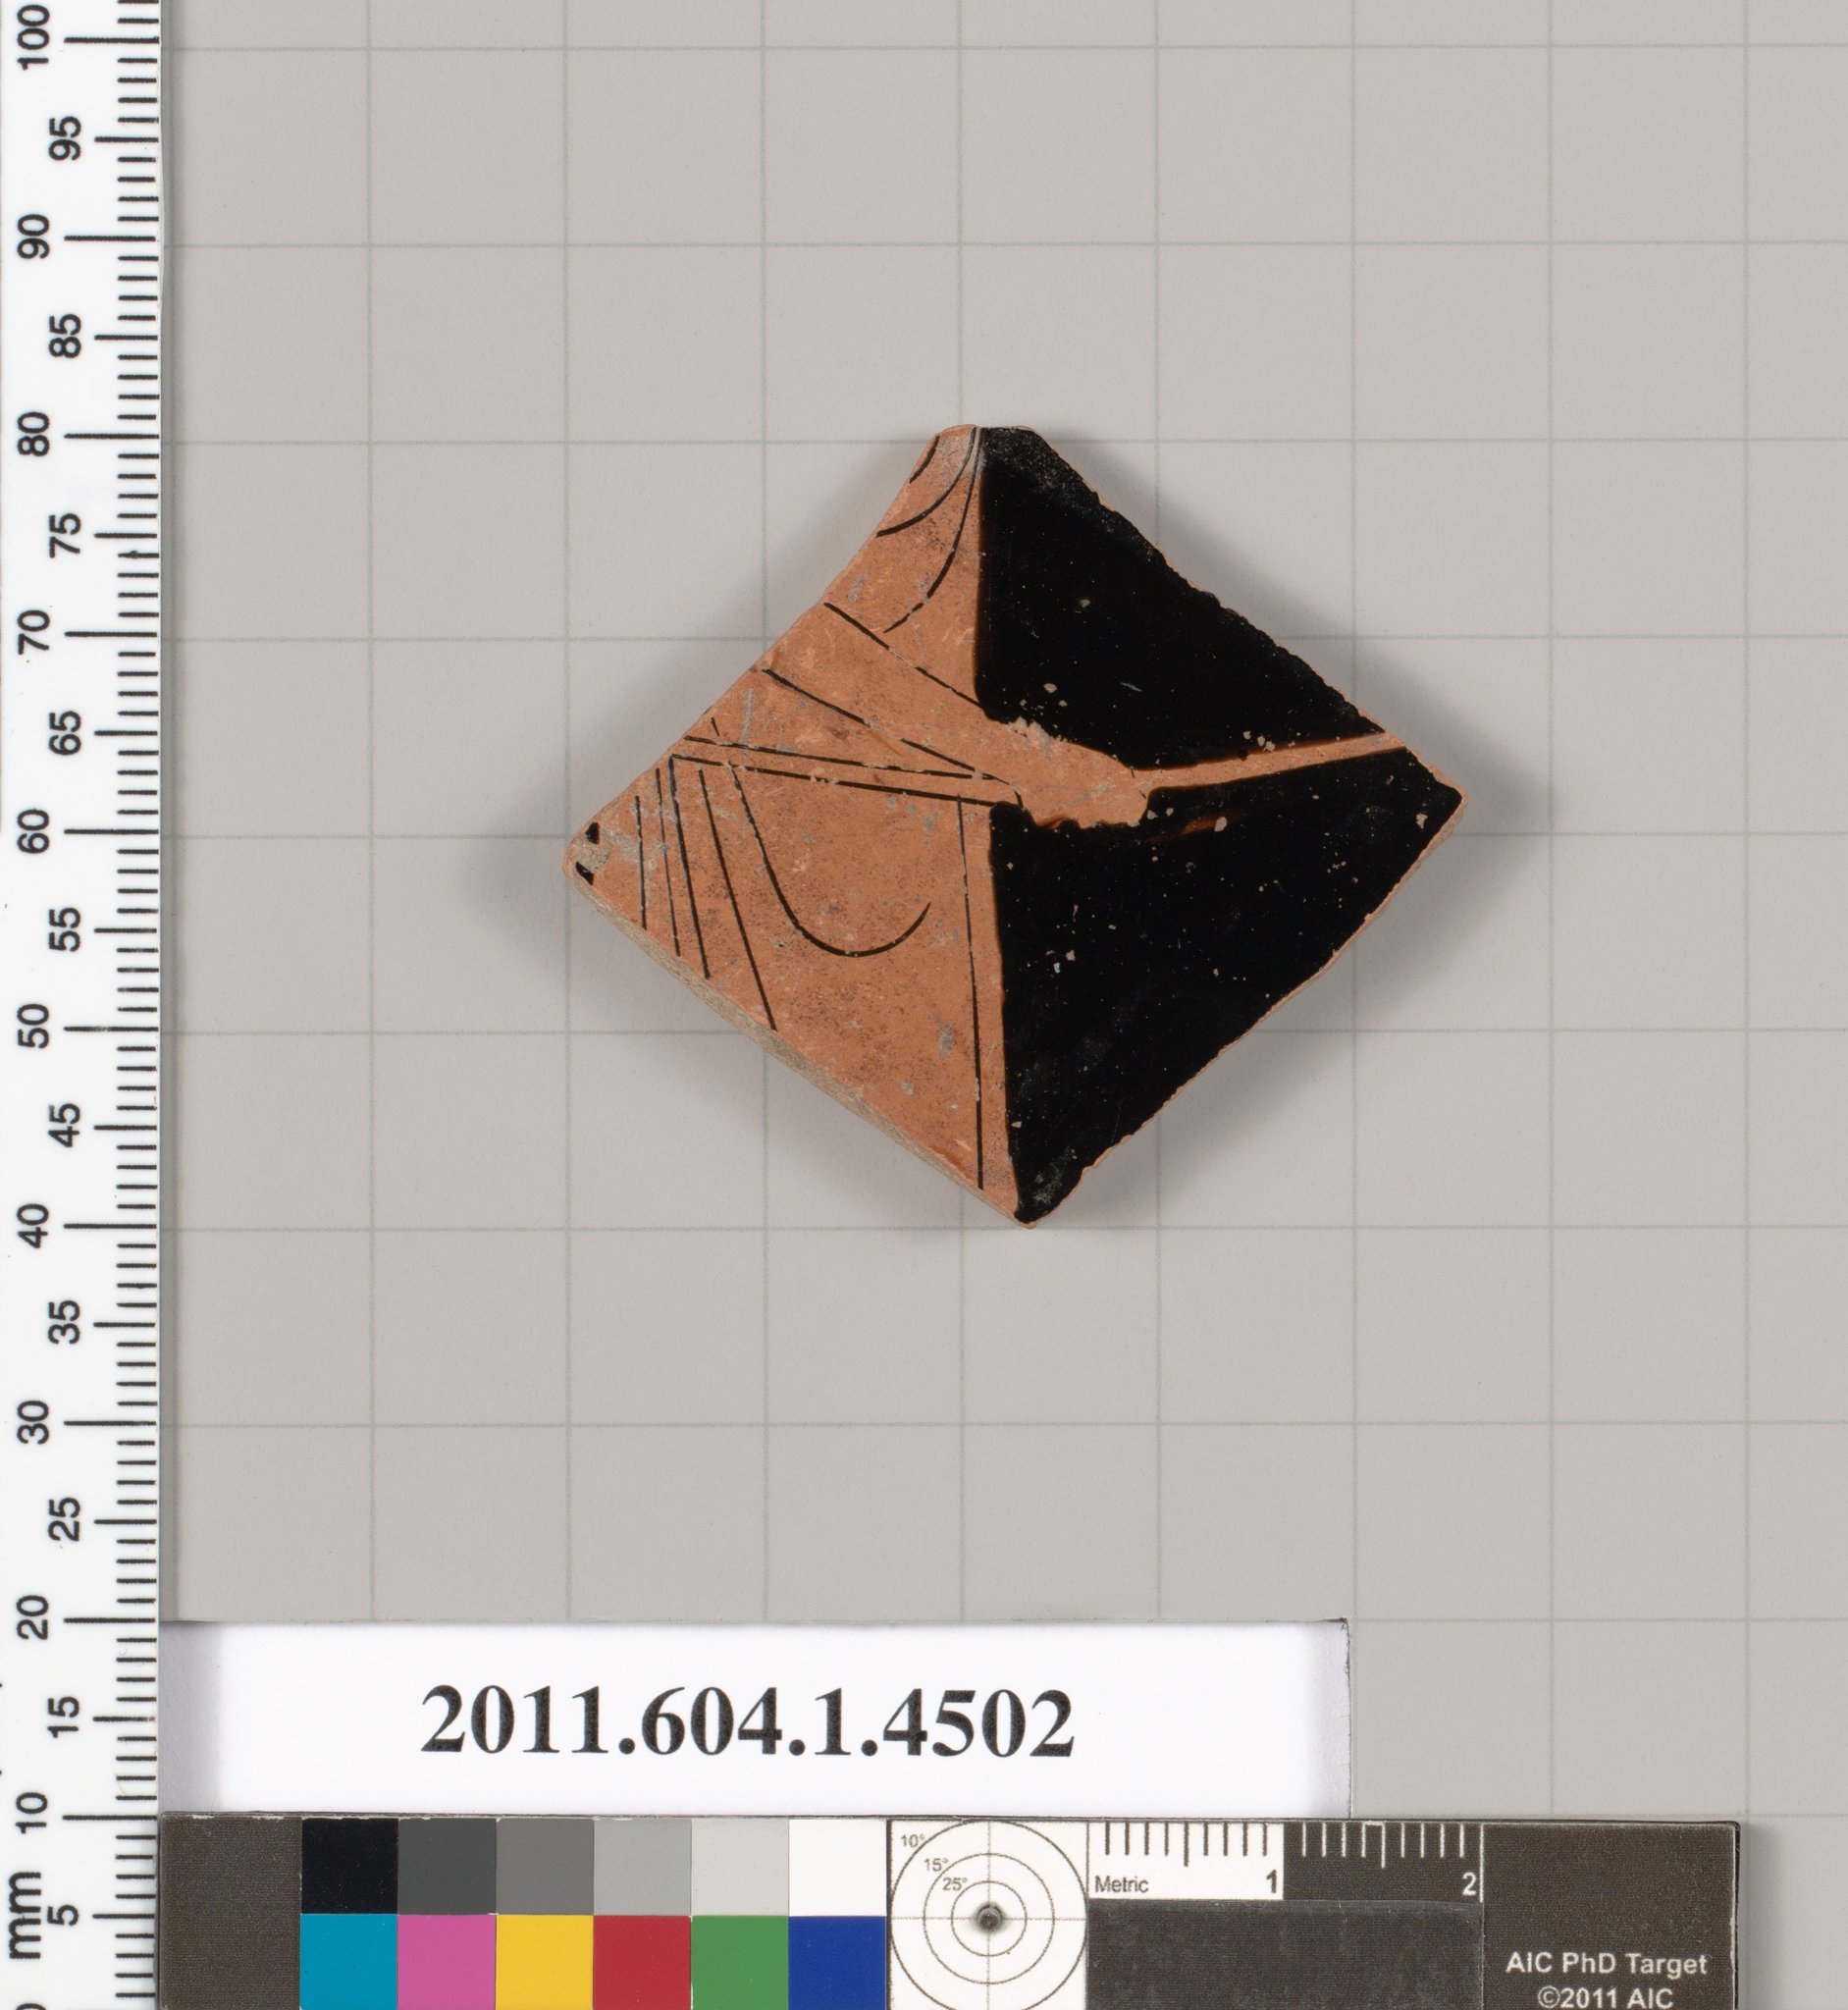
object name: kylix fragment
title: Terracotta fragment of a kylix (drinking cup)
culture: greek, attic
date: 500-476 BCE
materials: terracotta